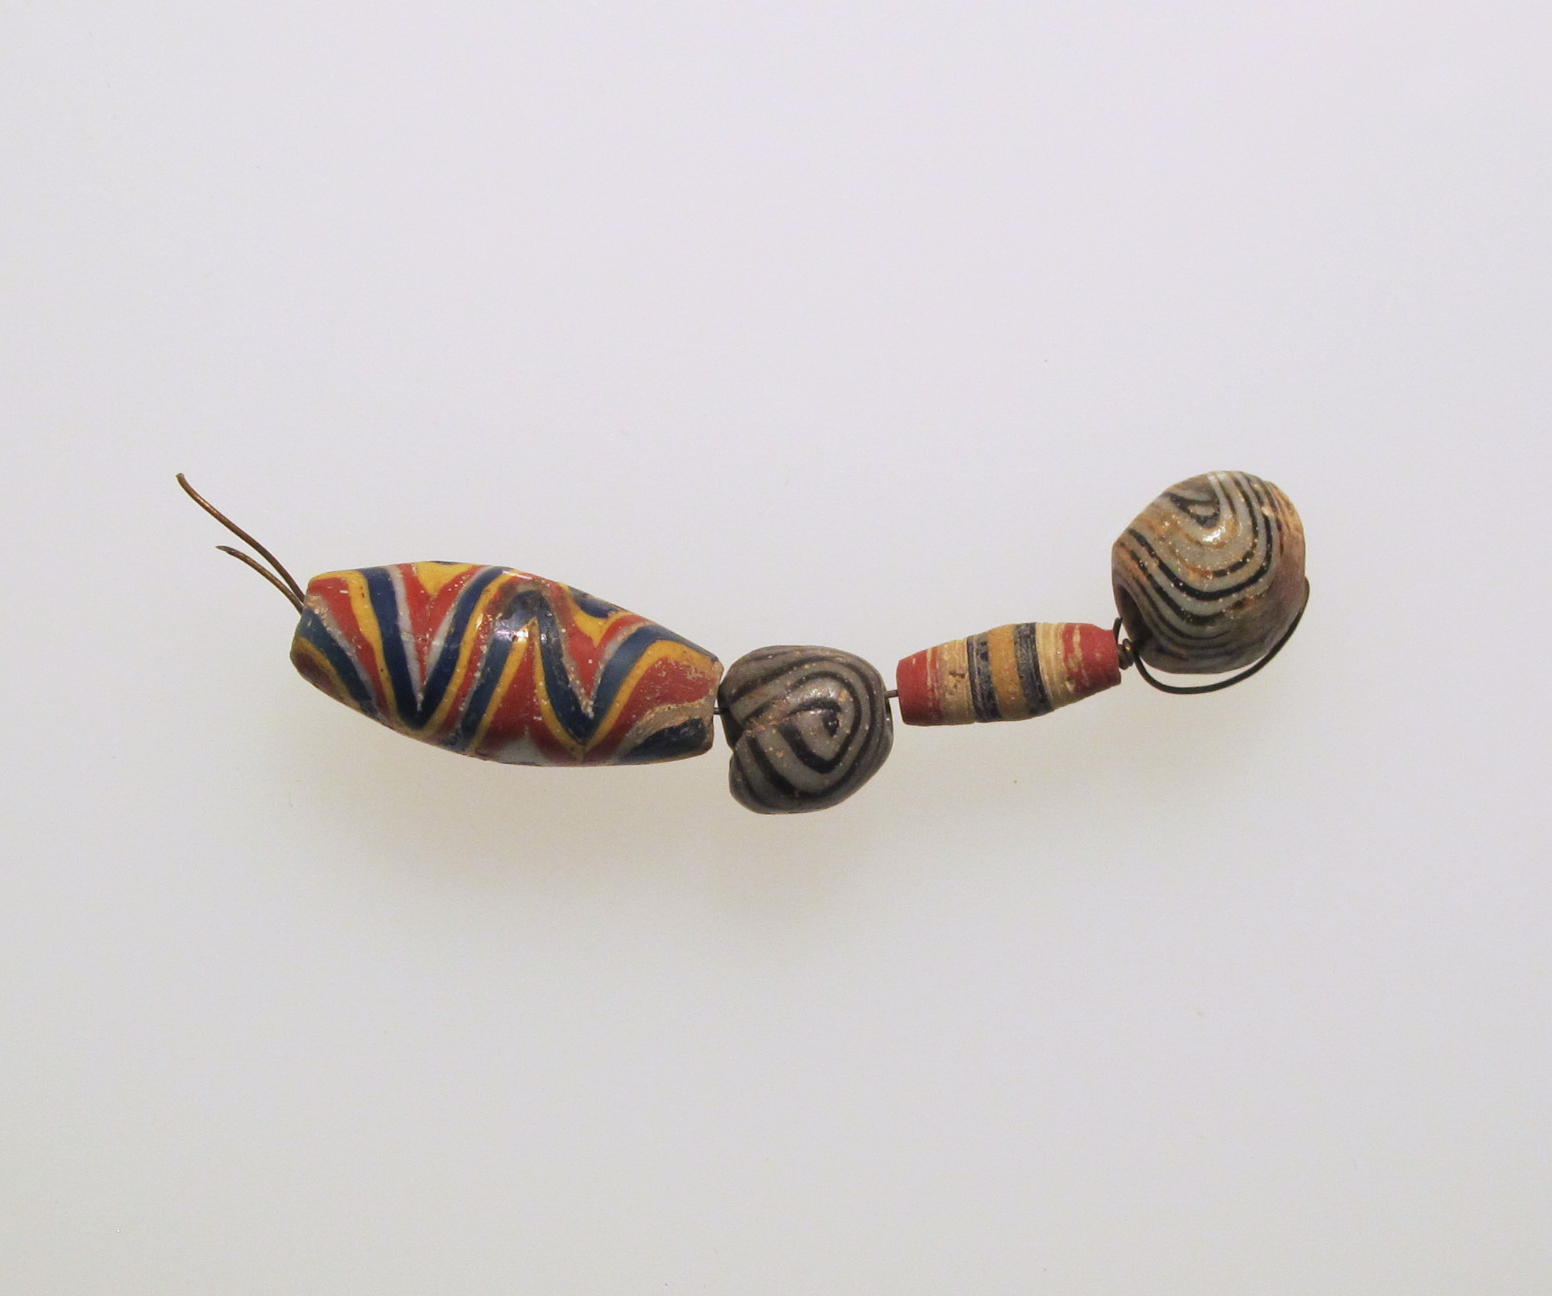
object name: bead, 5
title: Glass beads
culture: roman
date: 101-200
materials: glass